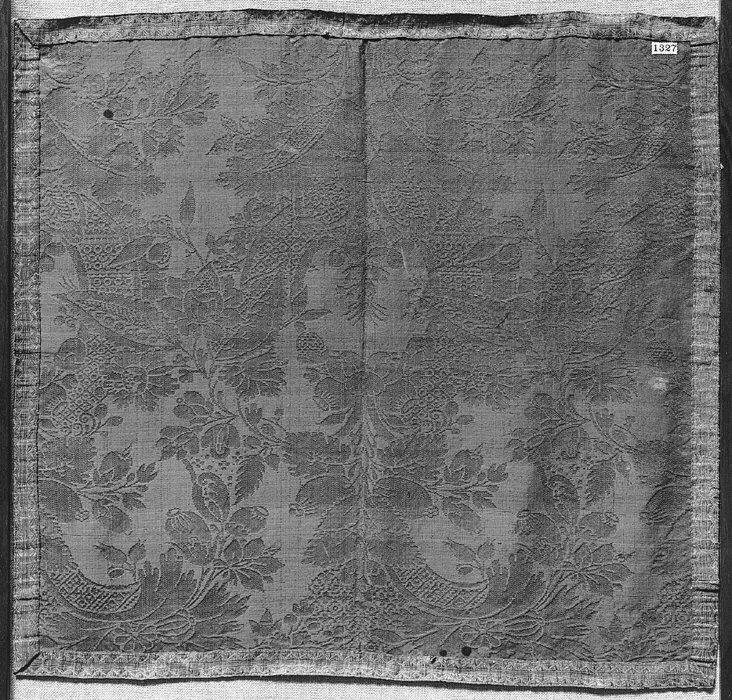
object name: piece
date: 1720-1730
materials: silk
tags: flowers,leaves